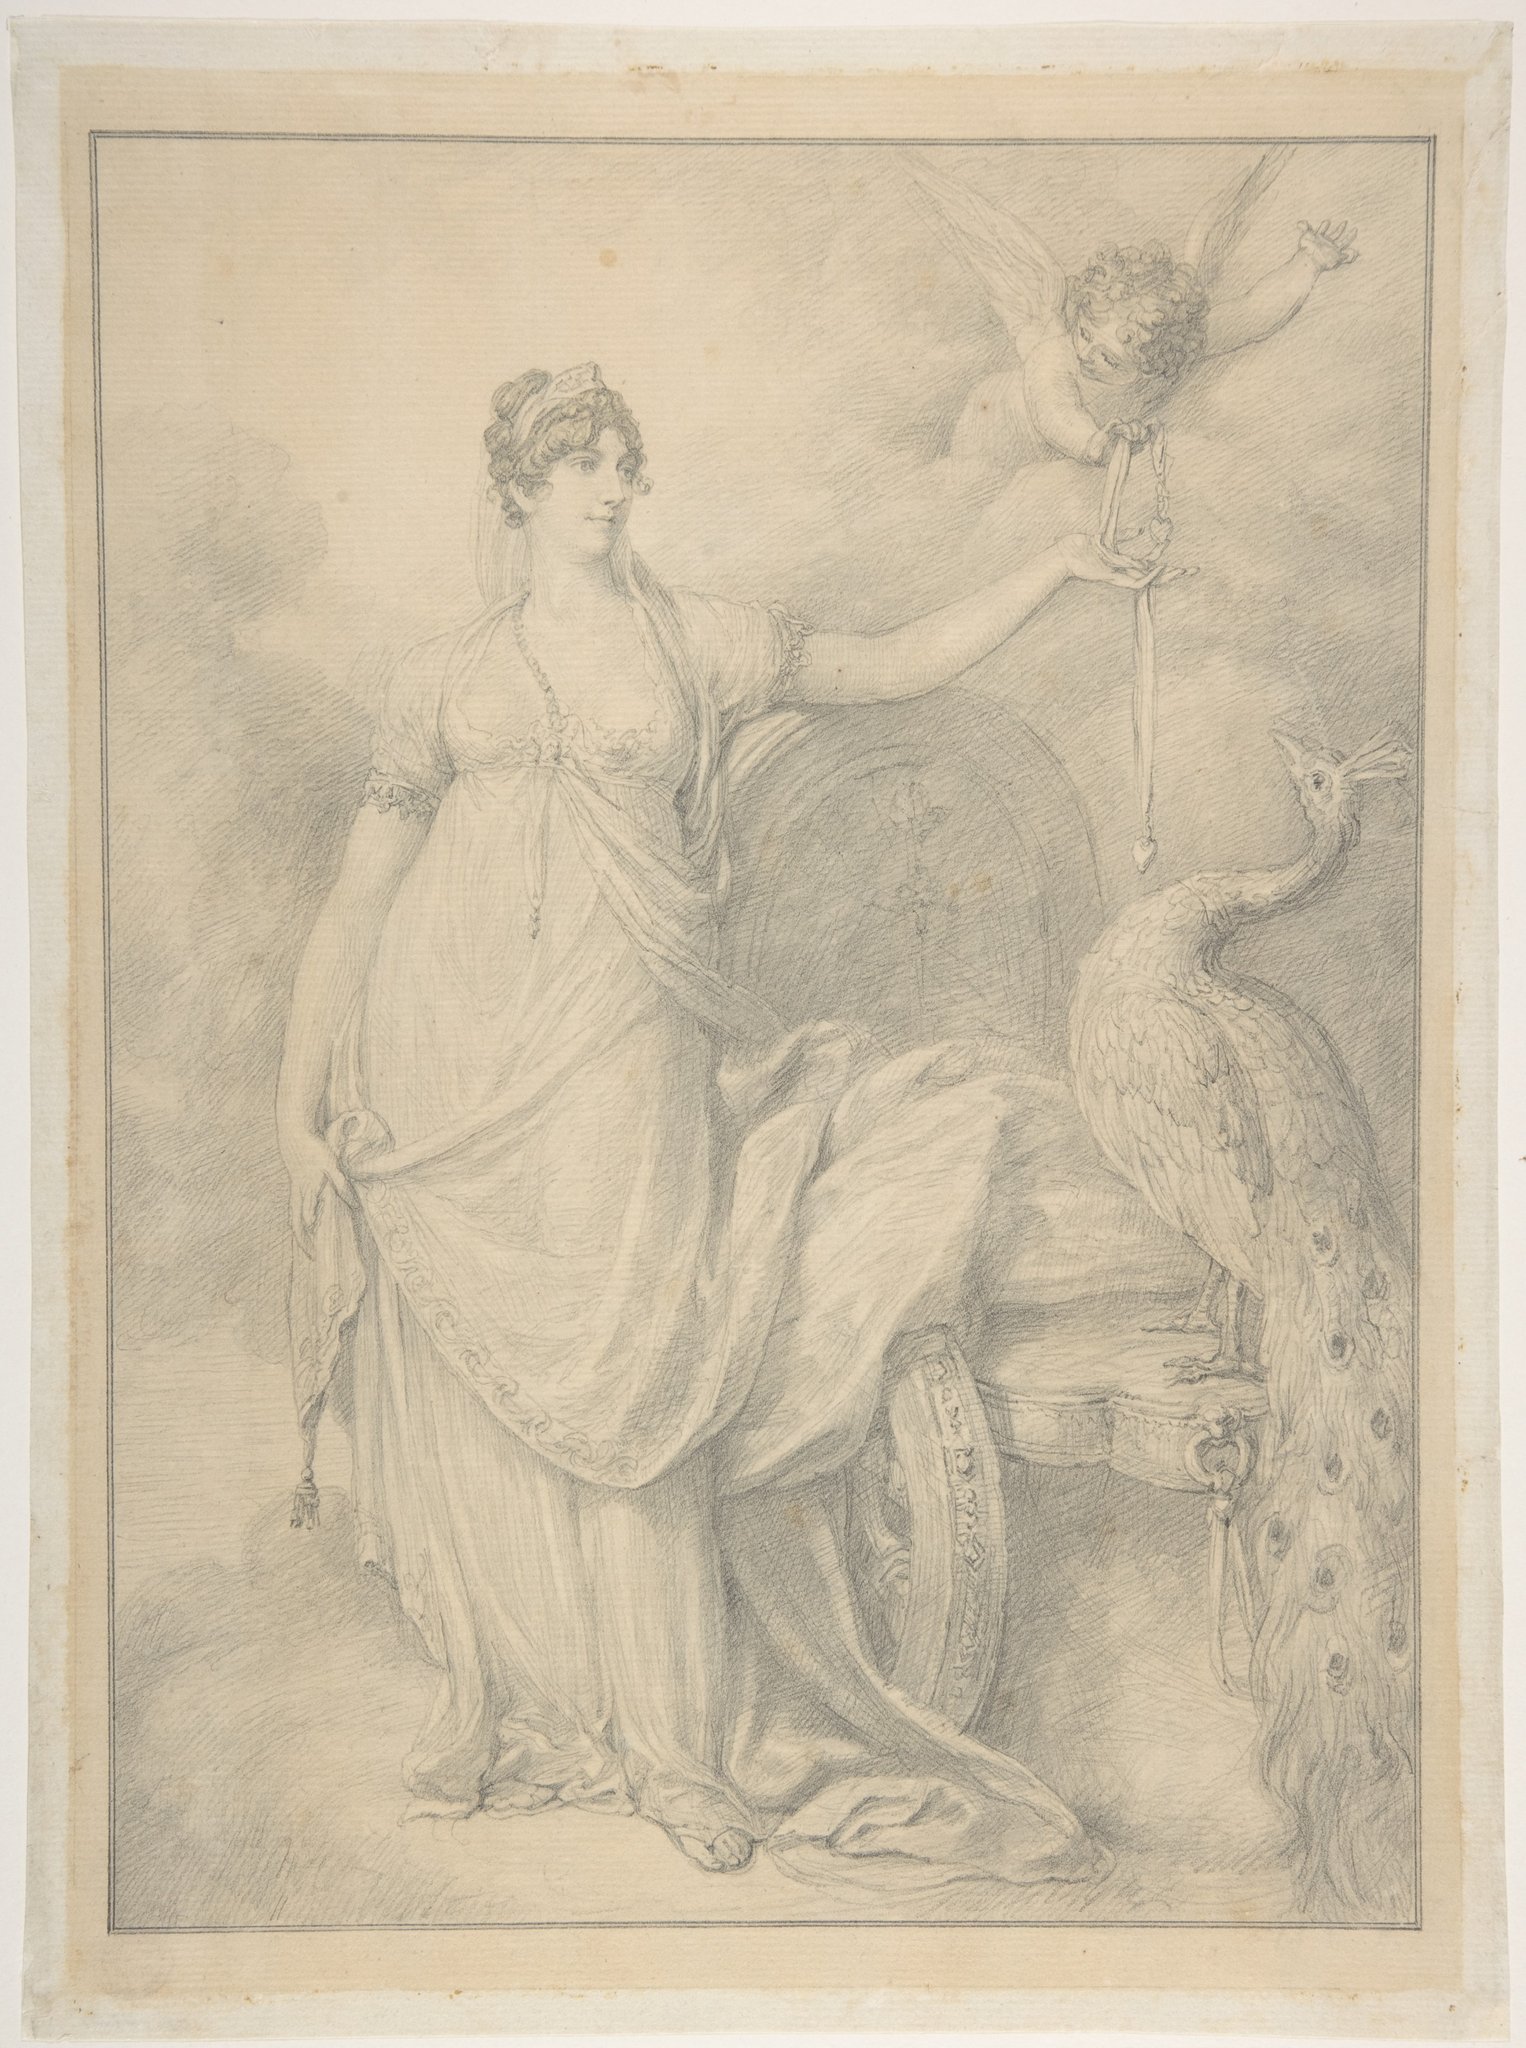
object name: drawing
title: Lavinia, Countess Spencer as Juno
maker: richard cosway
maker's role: artist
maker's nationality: british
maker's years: 1742-1821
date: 1806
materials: graphite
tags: cupid,juno,peacocks